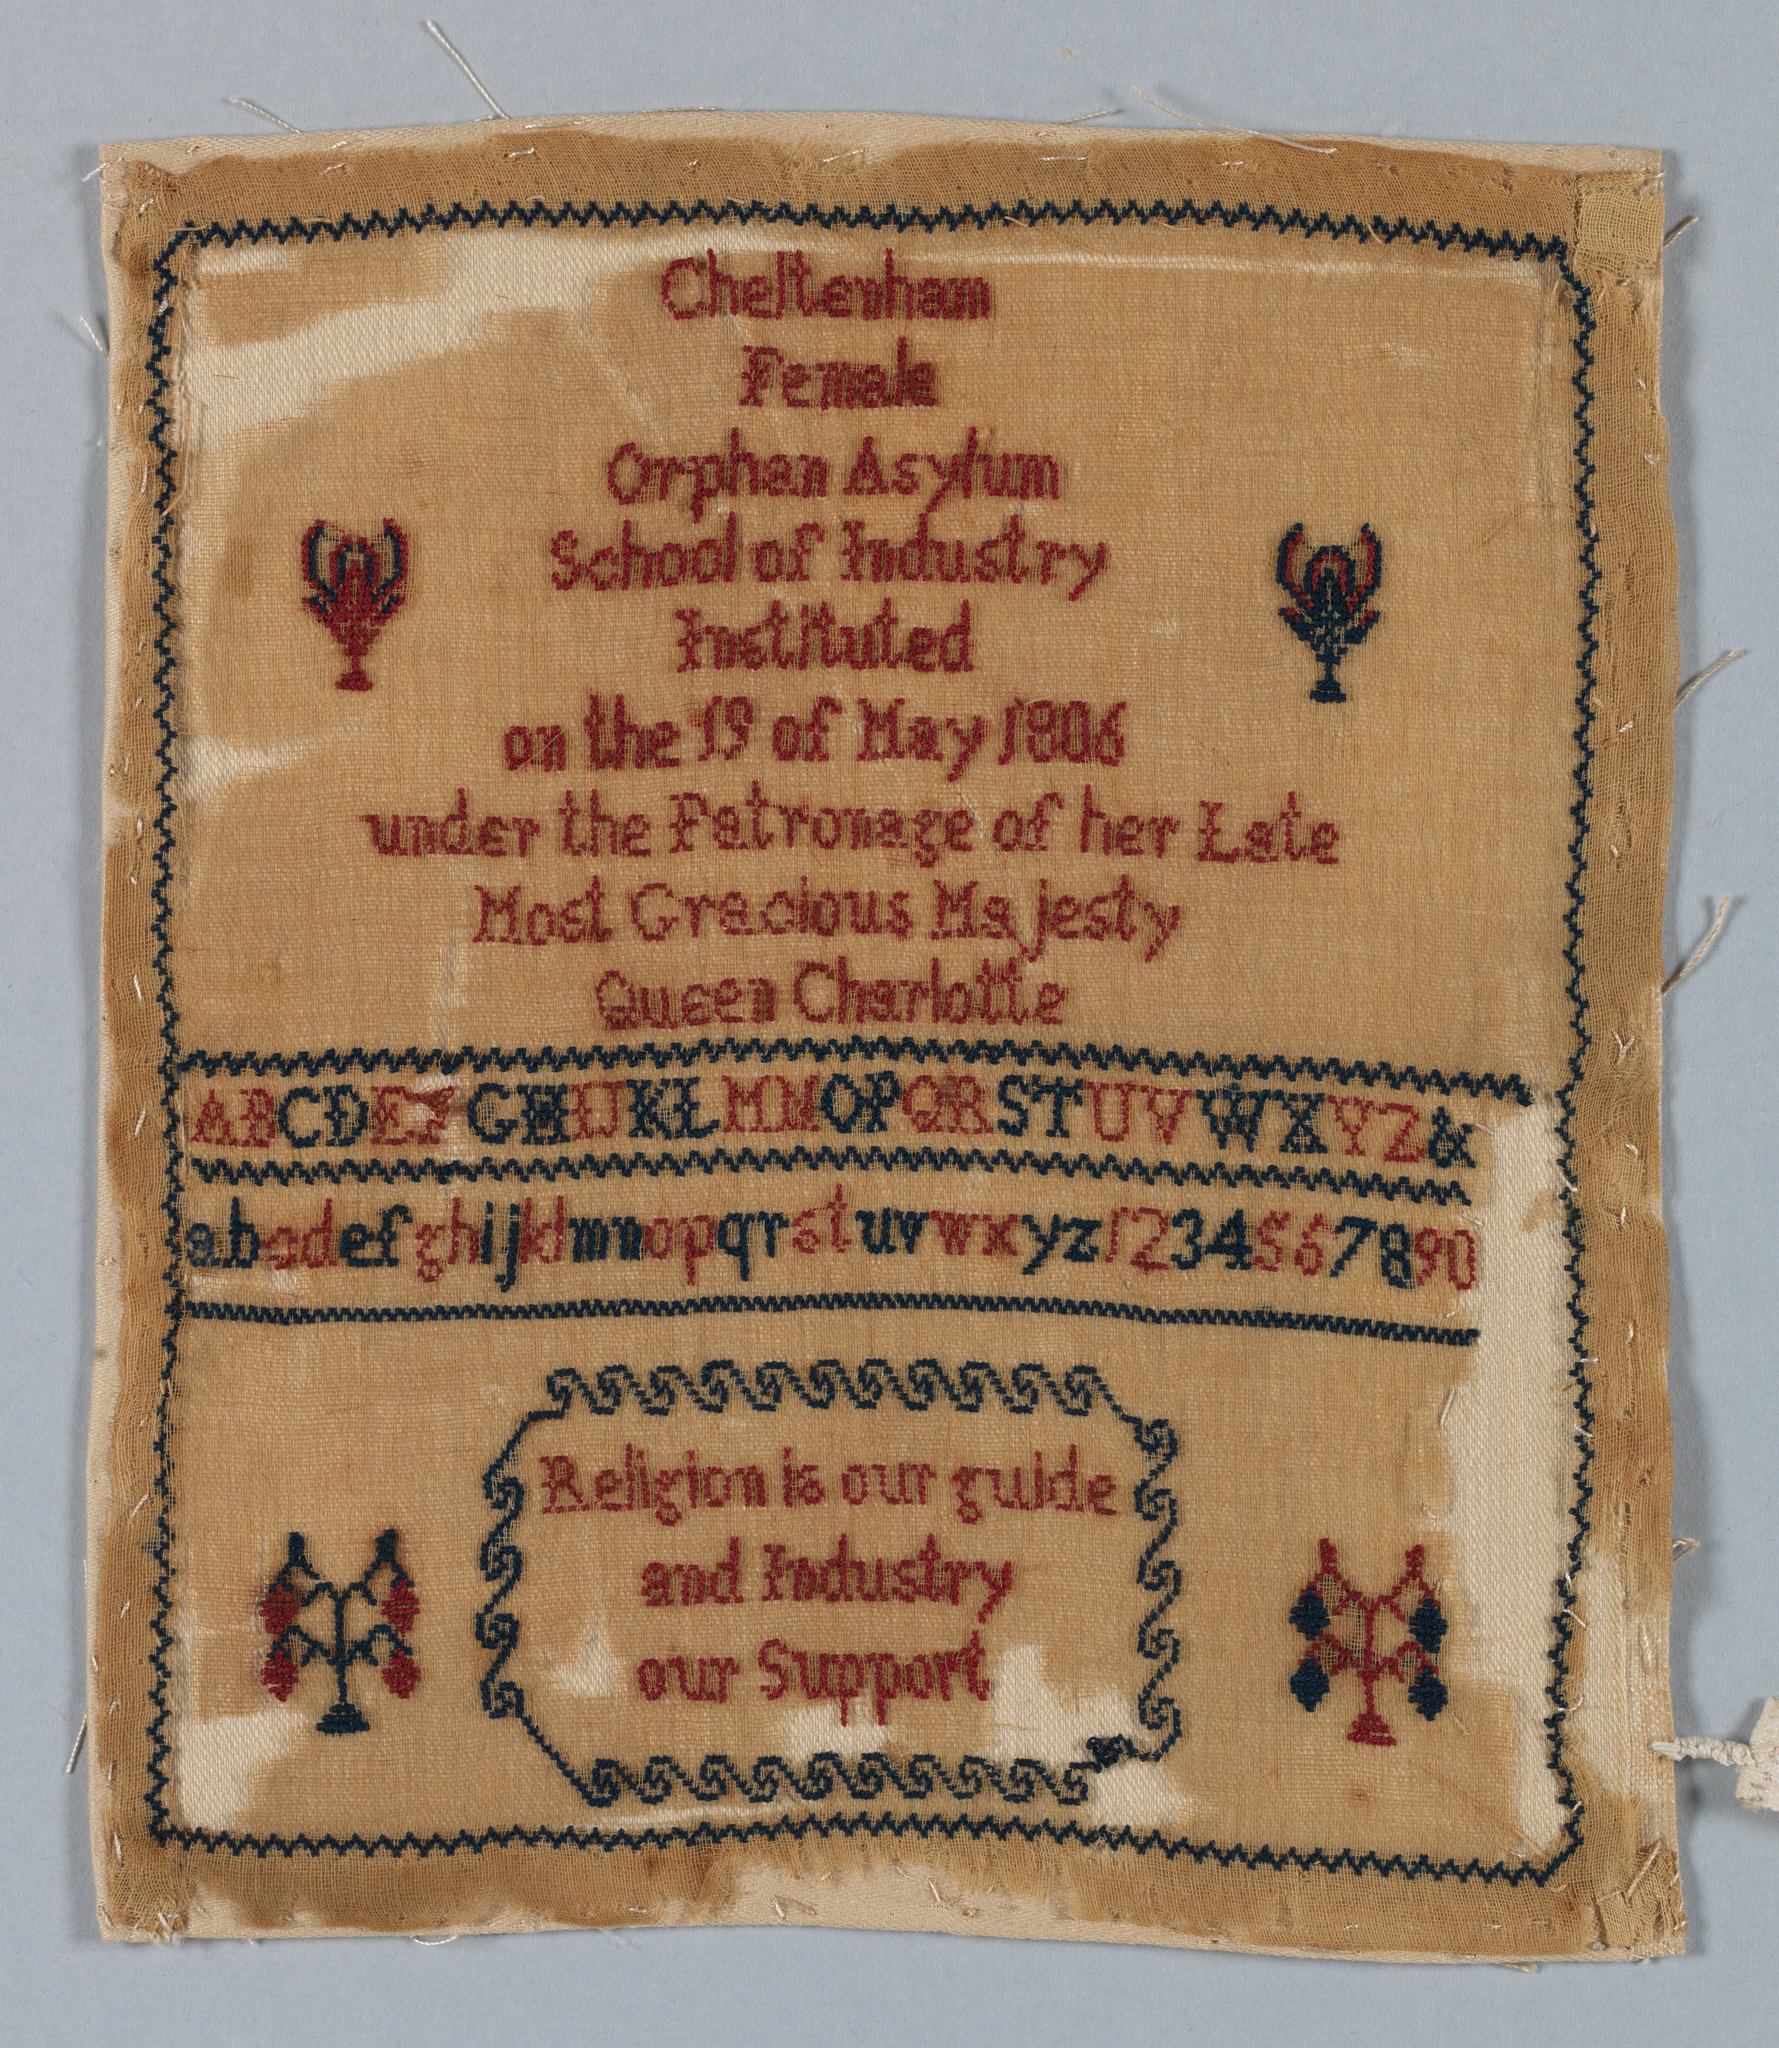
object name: sampler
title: Orphan sampler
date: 1806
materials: cotton, silk